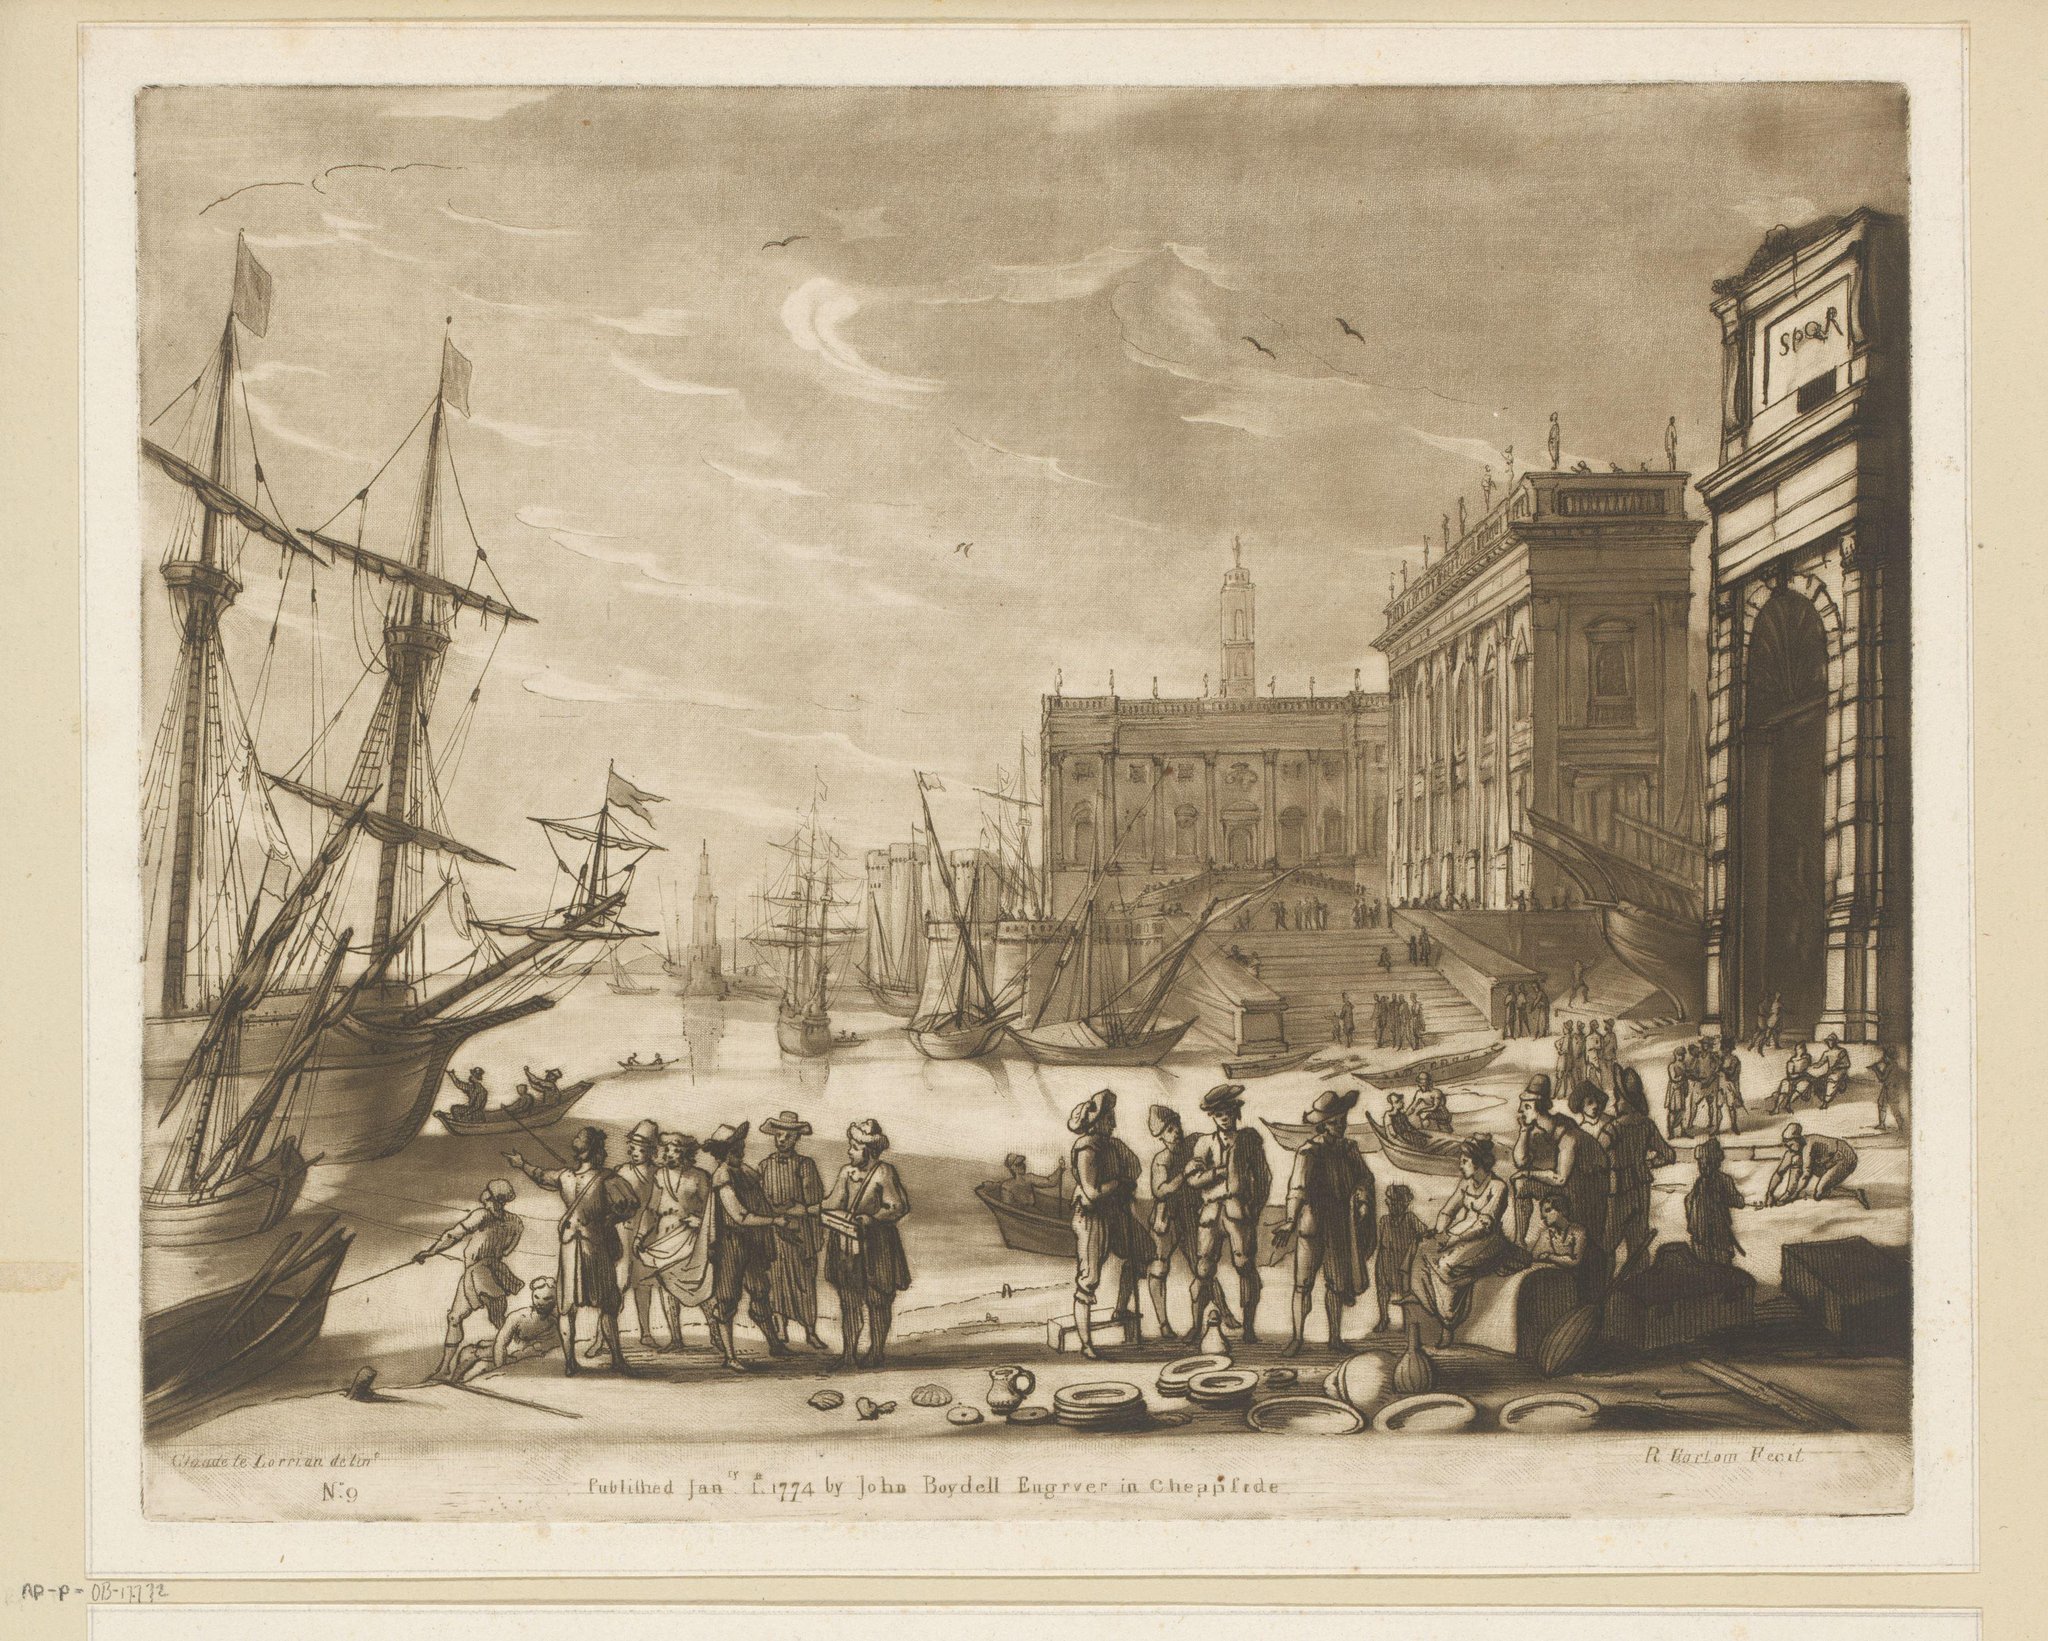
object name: print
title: Prenten naar tekeningen van Claude Lorrain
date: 1774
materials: paper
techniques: etching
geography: london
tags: harbour, city-view, and landscape with man-made constructions, market, city-gate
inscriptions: date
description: Vanaf 1774 publiceerde John Boydell tweehonderd prenten naar het tekeningenboek Liber Veritatis van Claude Lorrain, in het bezit van de hertogen van Cavendish. Deze werden vanaf 1777 in twee volumes gebundeld uitgegeven.